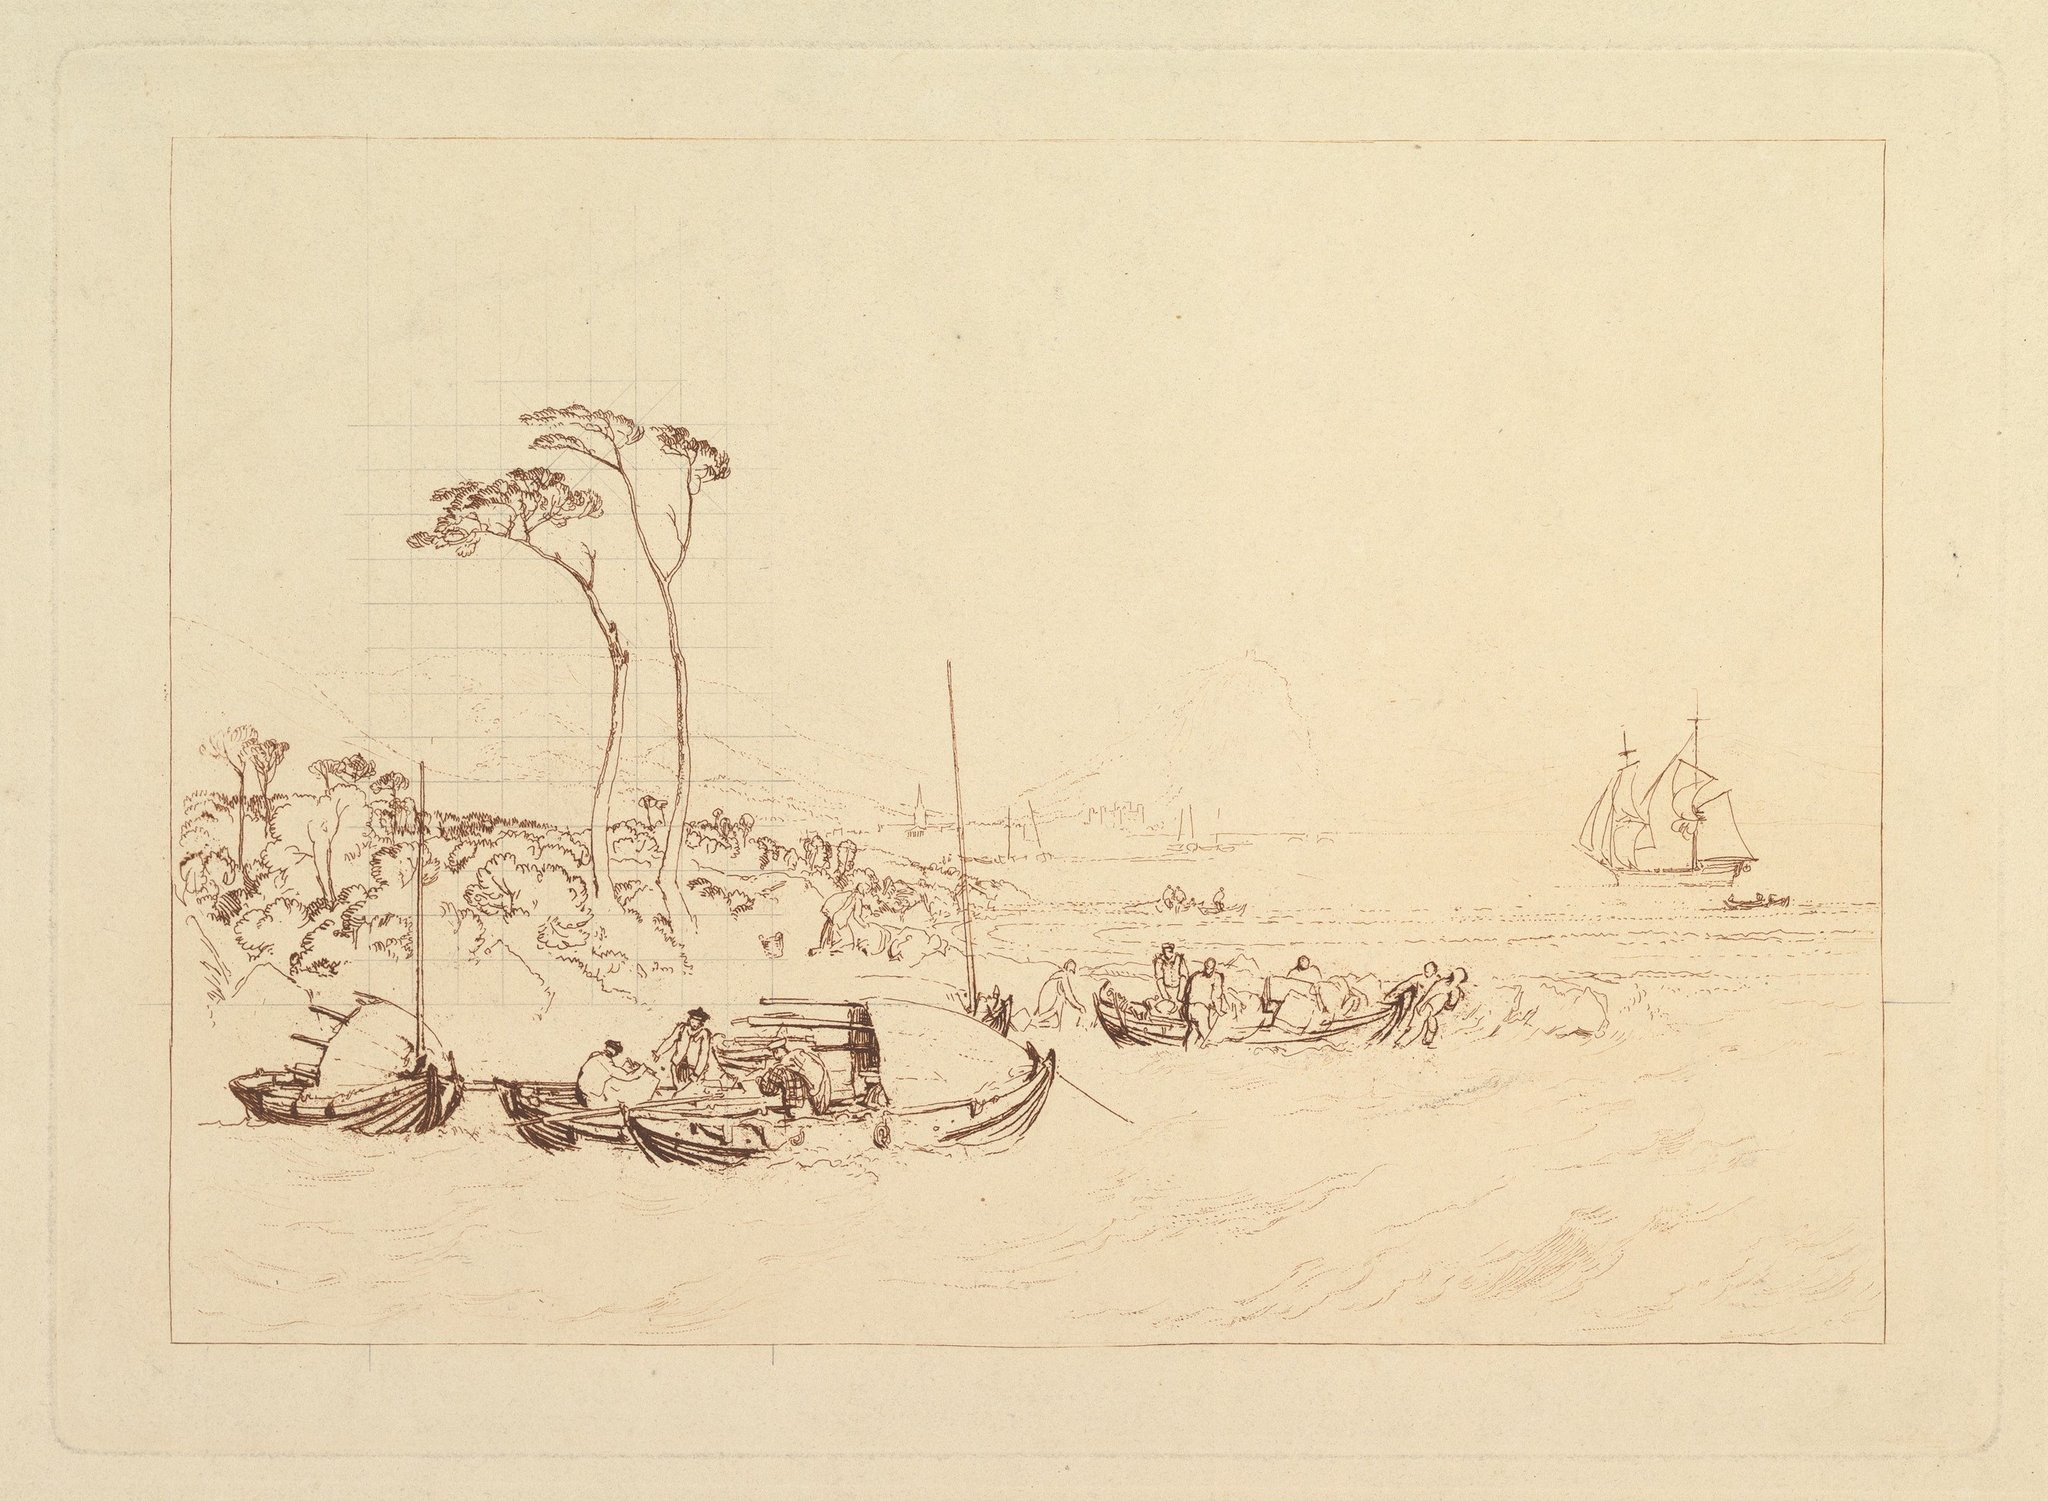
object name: print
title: Inverary Castle and Town, Scotland (Liber Studiorum, part XIII)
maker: joseph mallord william turner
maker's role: artist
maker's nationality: british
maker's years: 1775-1851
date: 1816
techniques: etching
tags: boats,ships